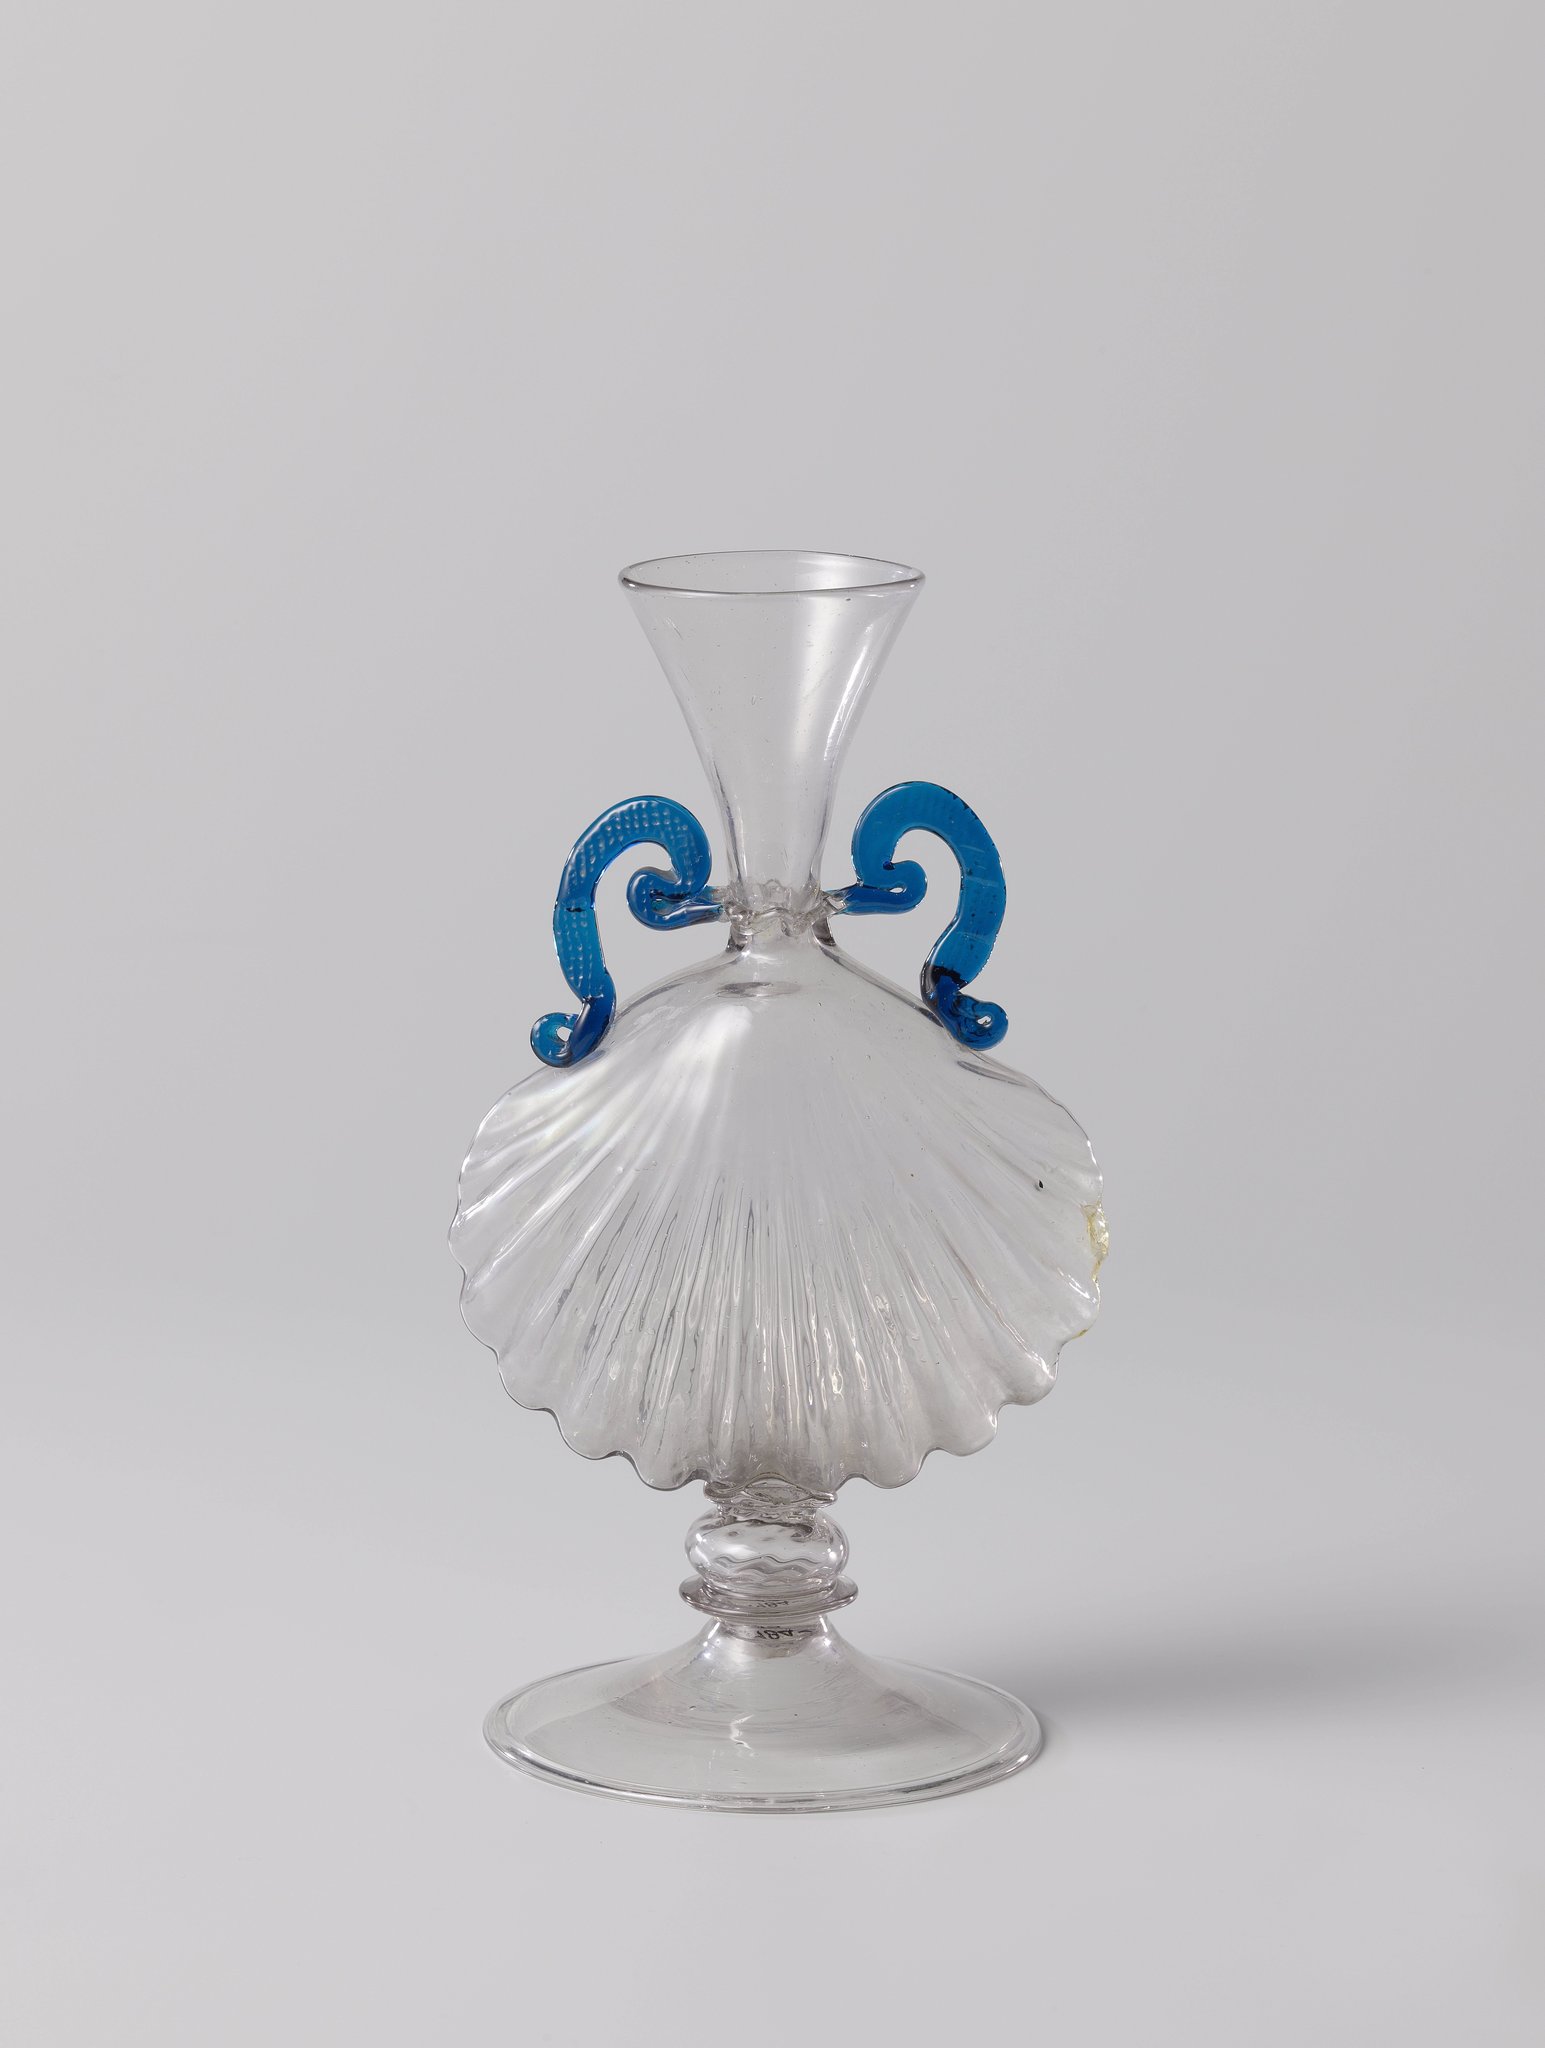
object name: flacon, flakon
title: Flacon met schelpvormige lichaam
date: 1600-1700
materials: glass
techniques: façon de venise, glassblowing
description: Flacon op platte voet met omgeslagen rand waarboven een holle, geribde en getordeerde nodus tussen twee schijven. Lichaam in de vorm van een St.-Jacobs-schelp. Trechtervormige hals, waaromheen een kleurloze gegolfde draad is gelegd. Ter weerszijden een plat S-vormig geknepen oor van blauw glas